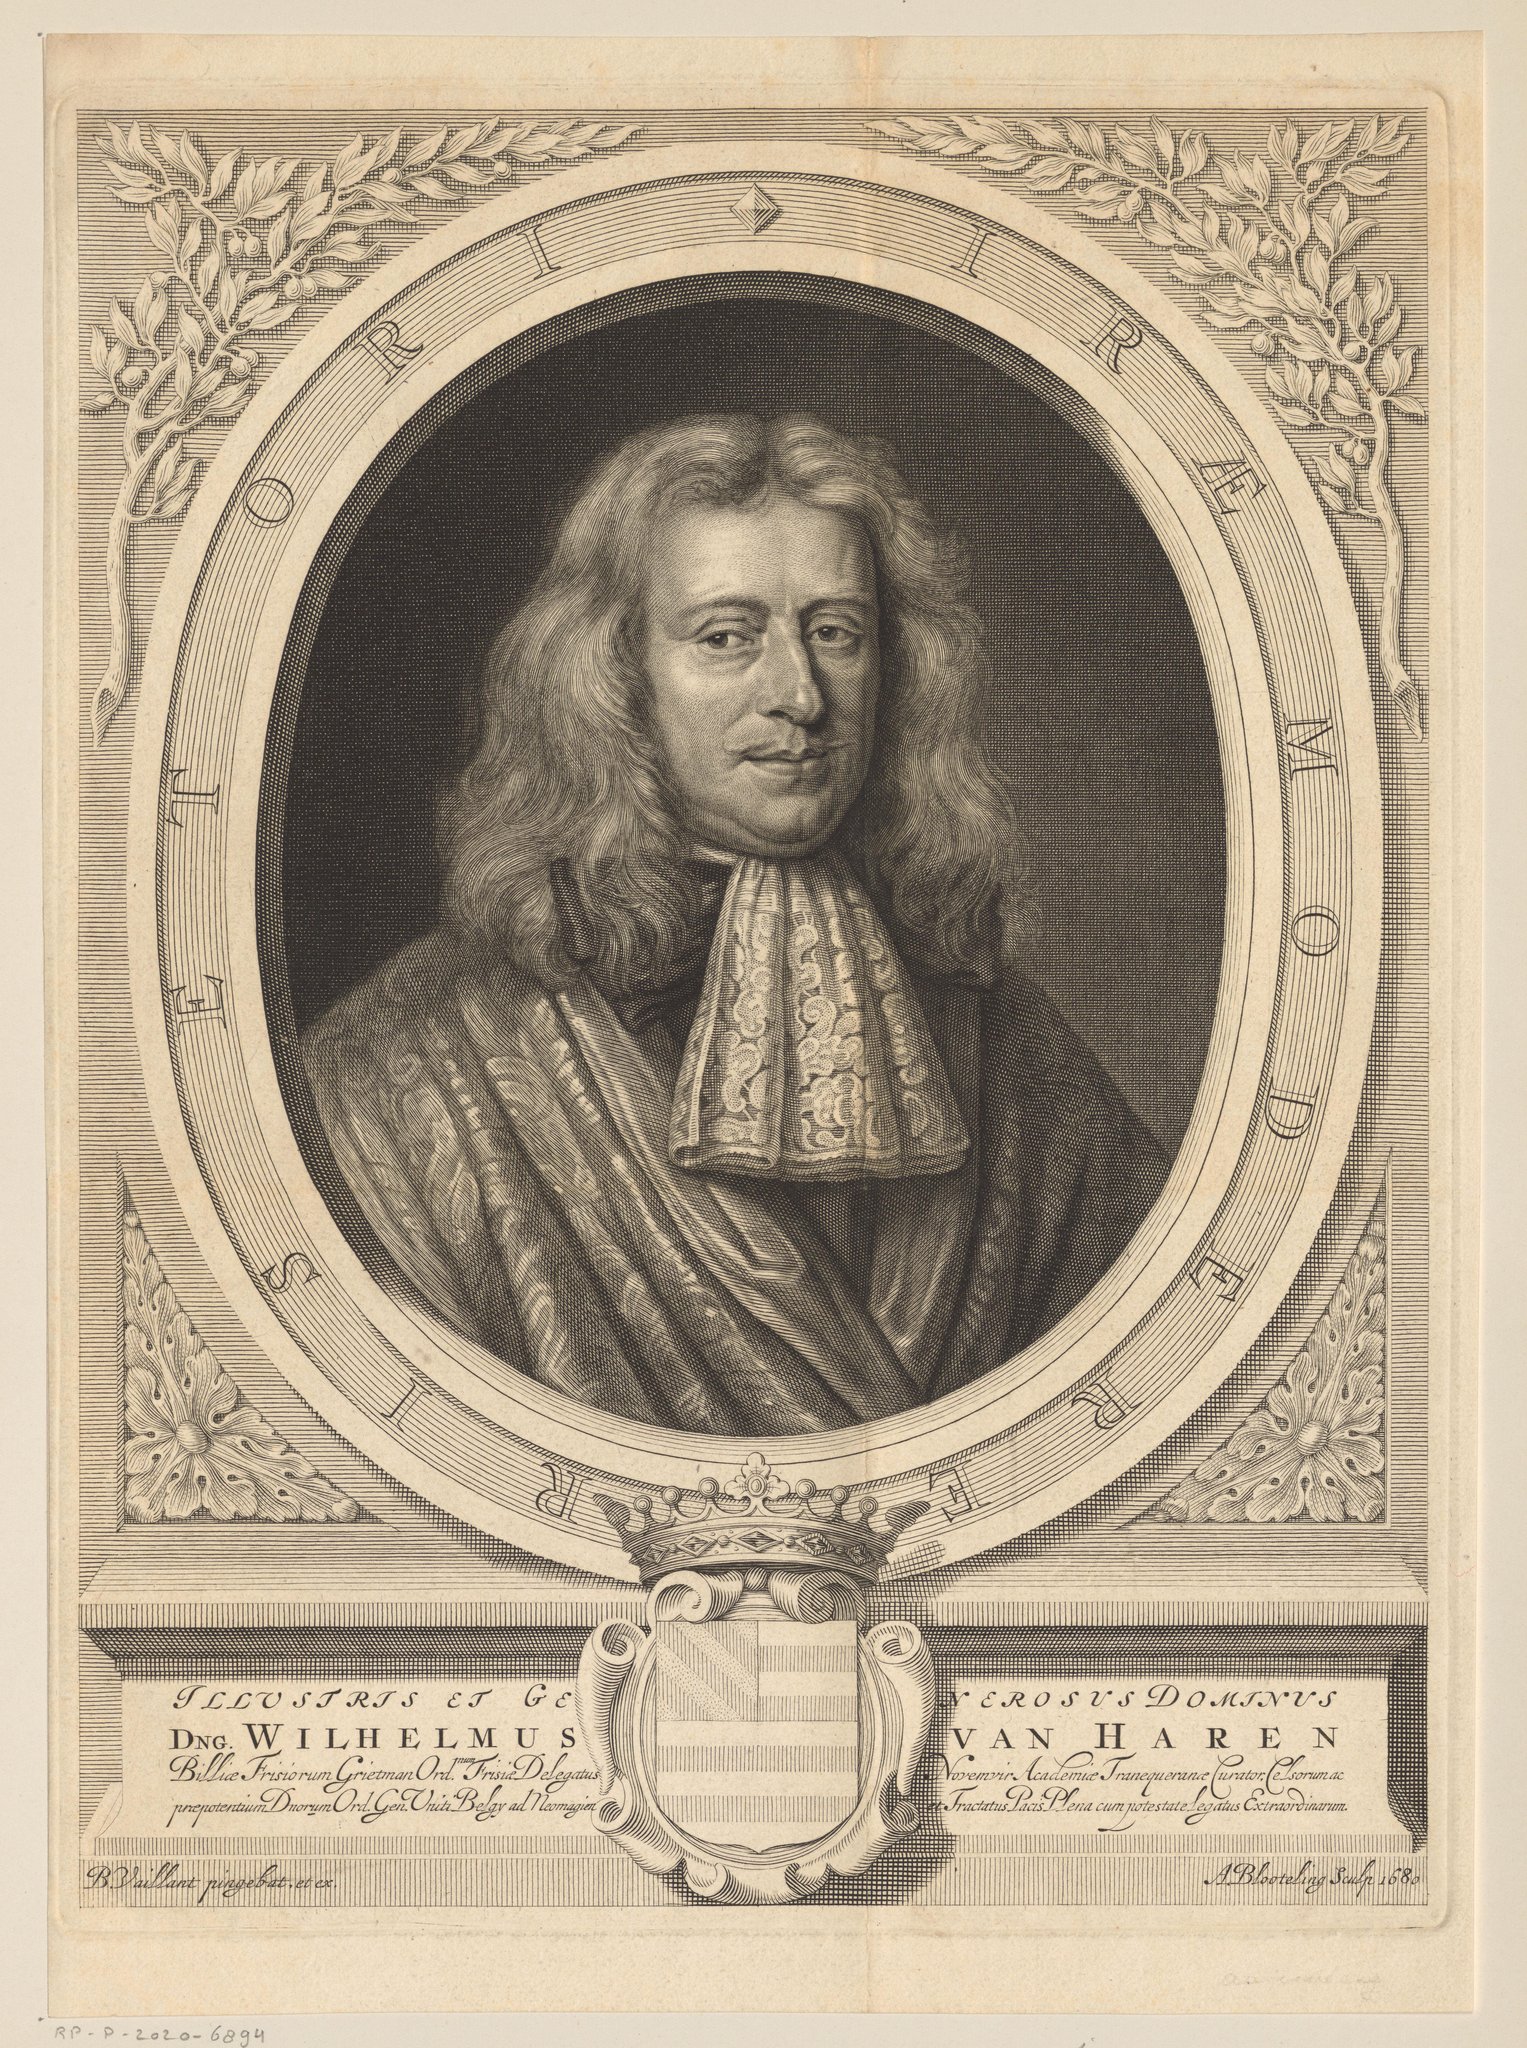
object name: print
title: Portret van Willem van Haren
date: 1680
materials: paper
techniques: engraving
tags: official; civil servant; functionary (in general), historical persons, armorial bearing, heraldry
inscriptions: date